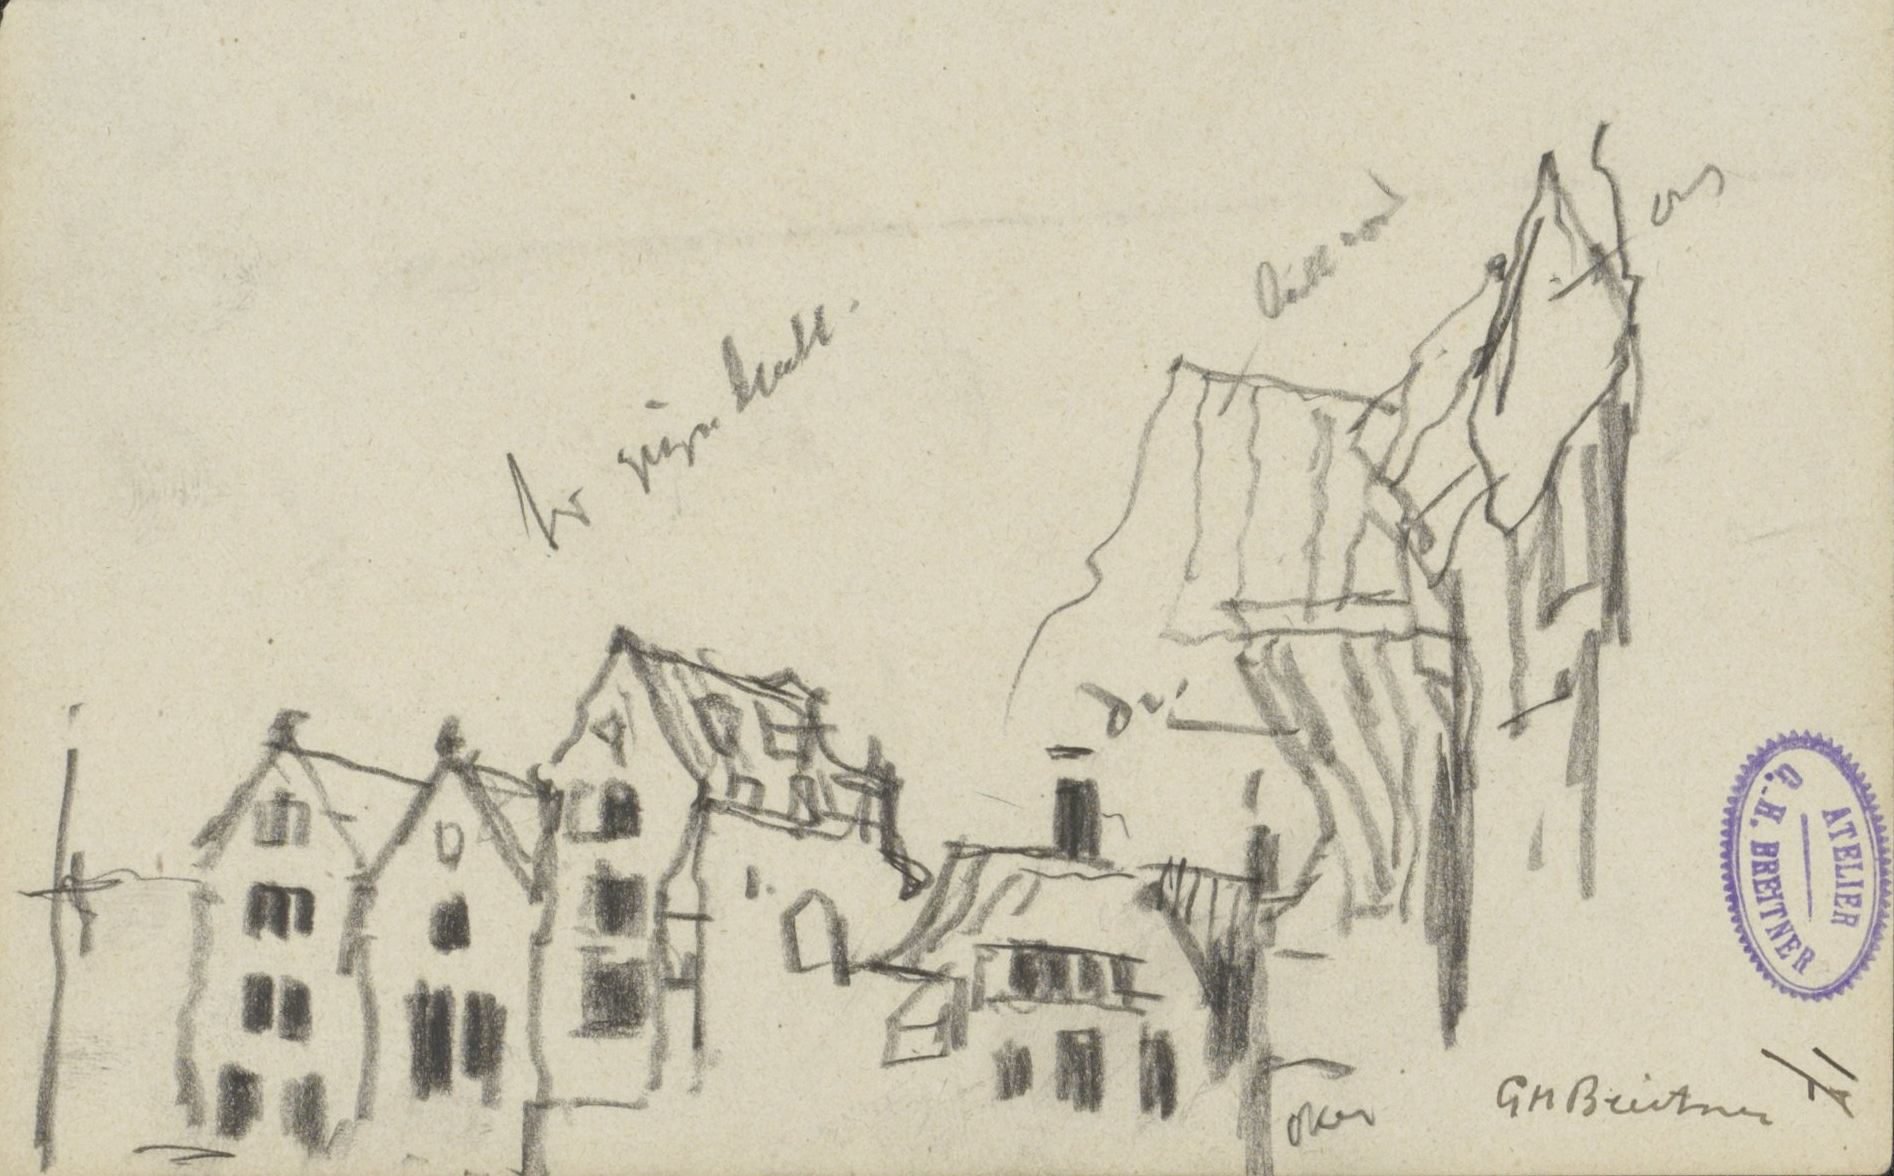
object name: drawing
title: Gezicht op pakhuizen te Amsterdam, mogelijk op de Westelijke Eilanden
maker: george hendrik breitner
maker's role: draughtsman, painter, print maker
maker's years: 1857-1923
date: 1912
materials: chalk, paper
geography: amsterdam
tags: large-scale structure for storage, e.g.: warehouse, depot, silo, city-view, and landscape with man-made constructions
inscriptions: workshop stamp: Lugt 291d, collector's mark: Lugt 2228, :, signature: ‘G H Breitner’